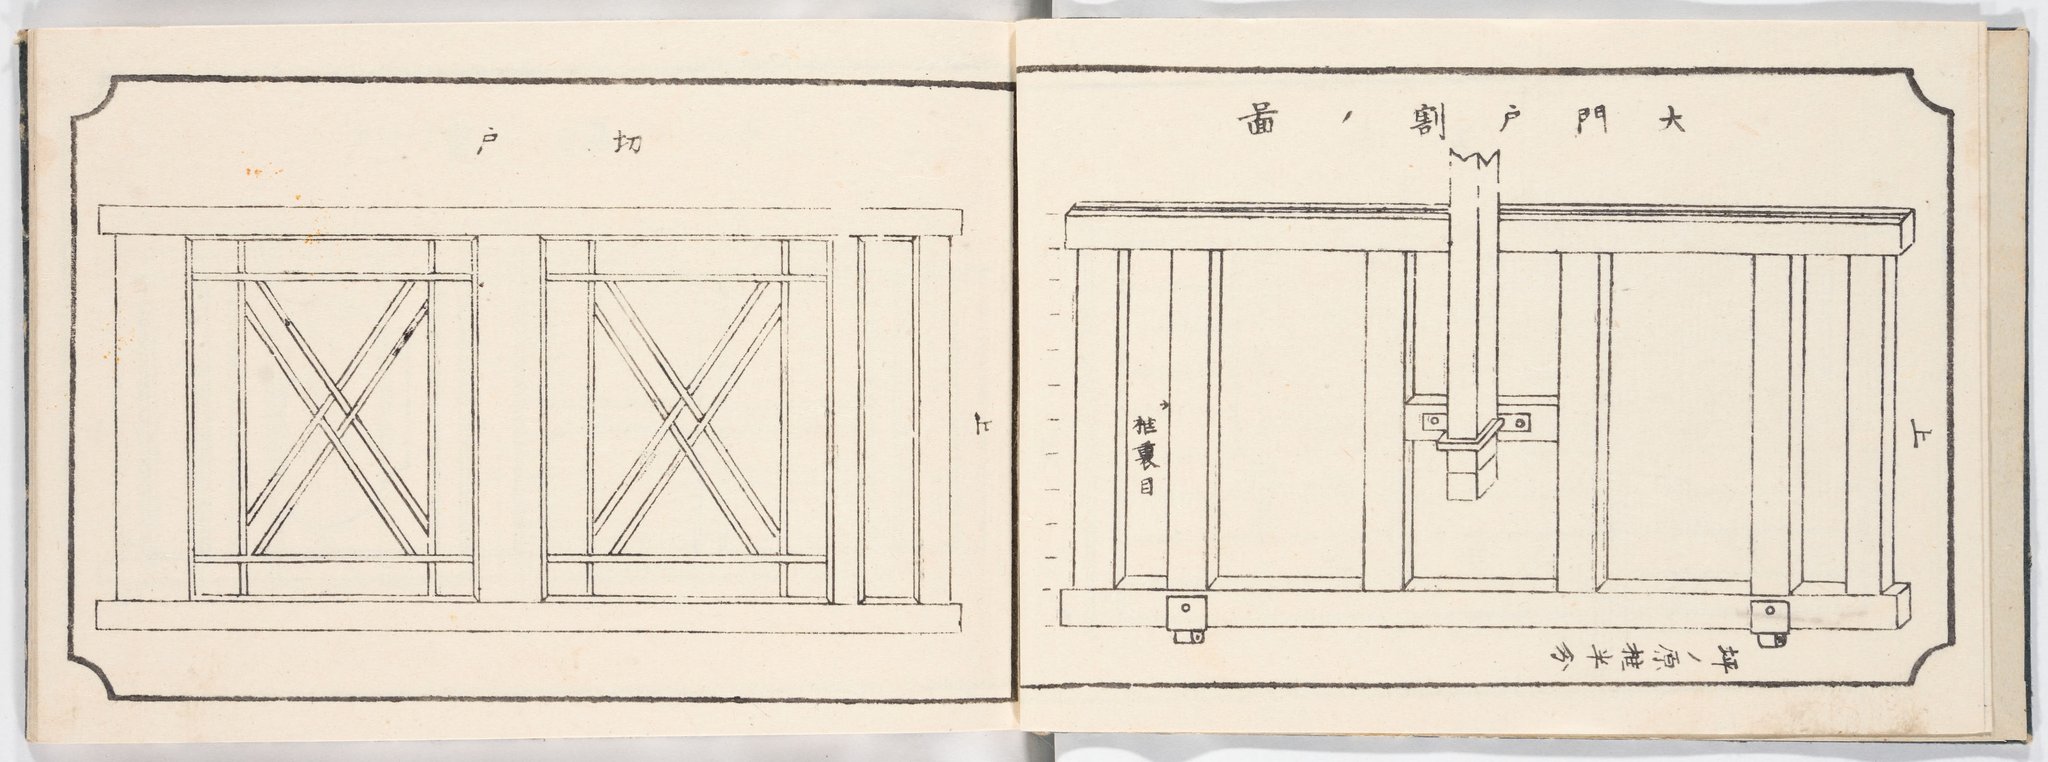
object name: illustrated book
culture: japanese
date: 1893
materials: ink, paper